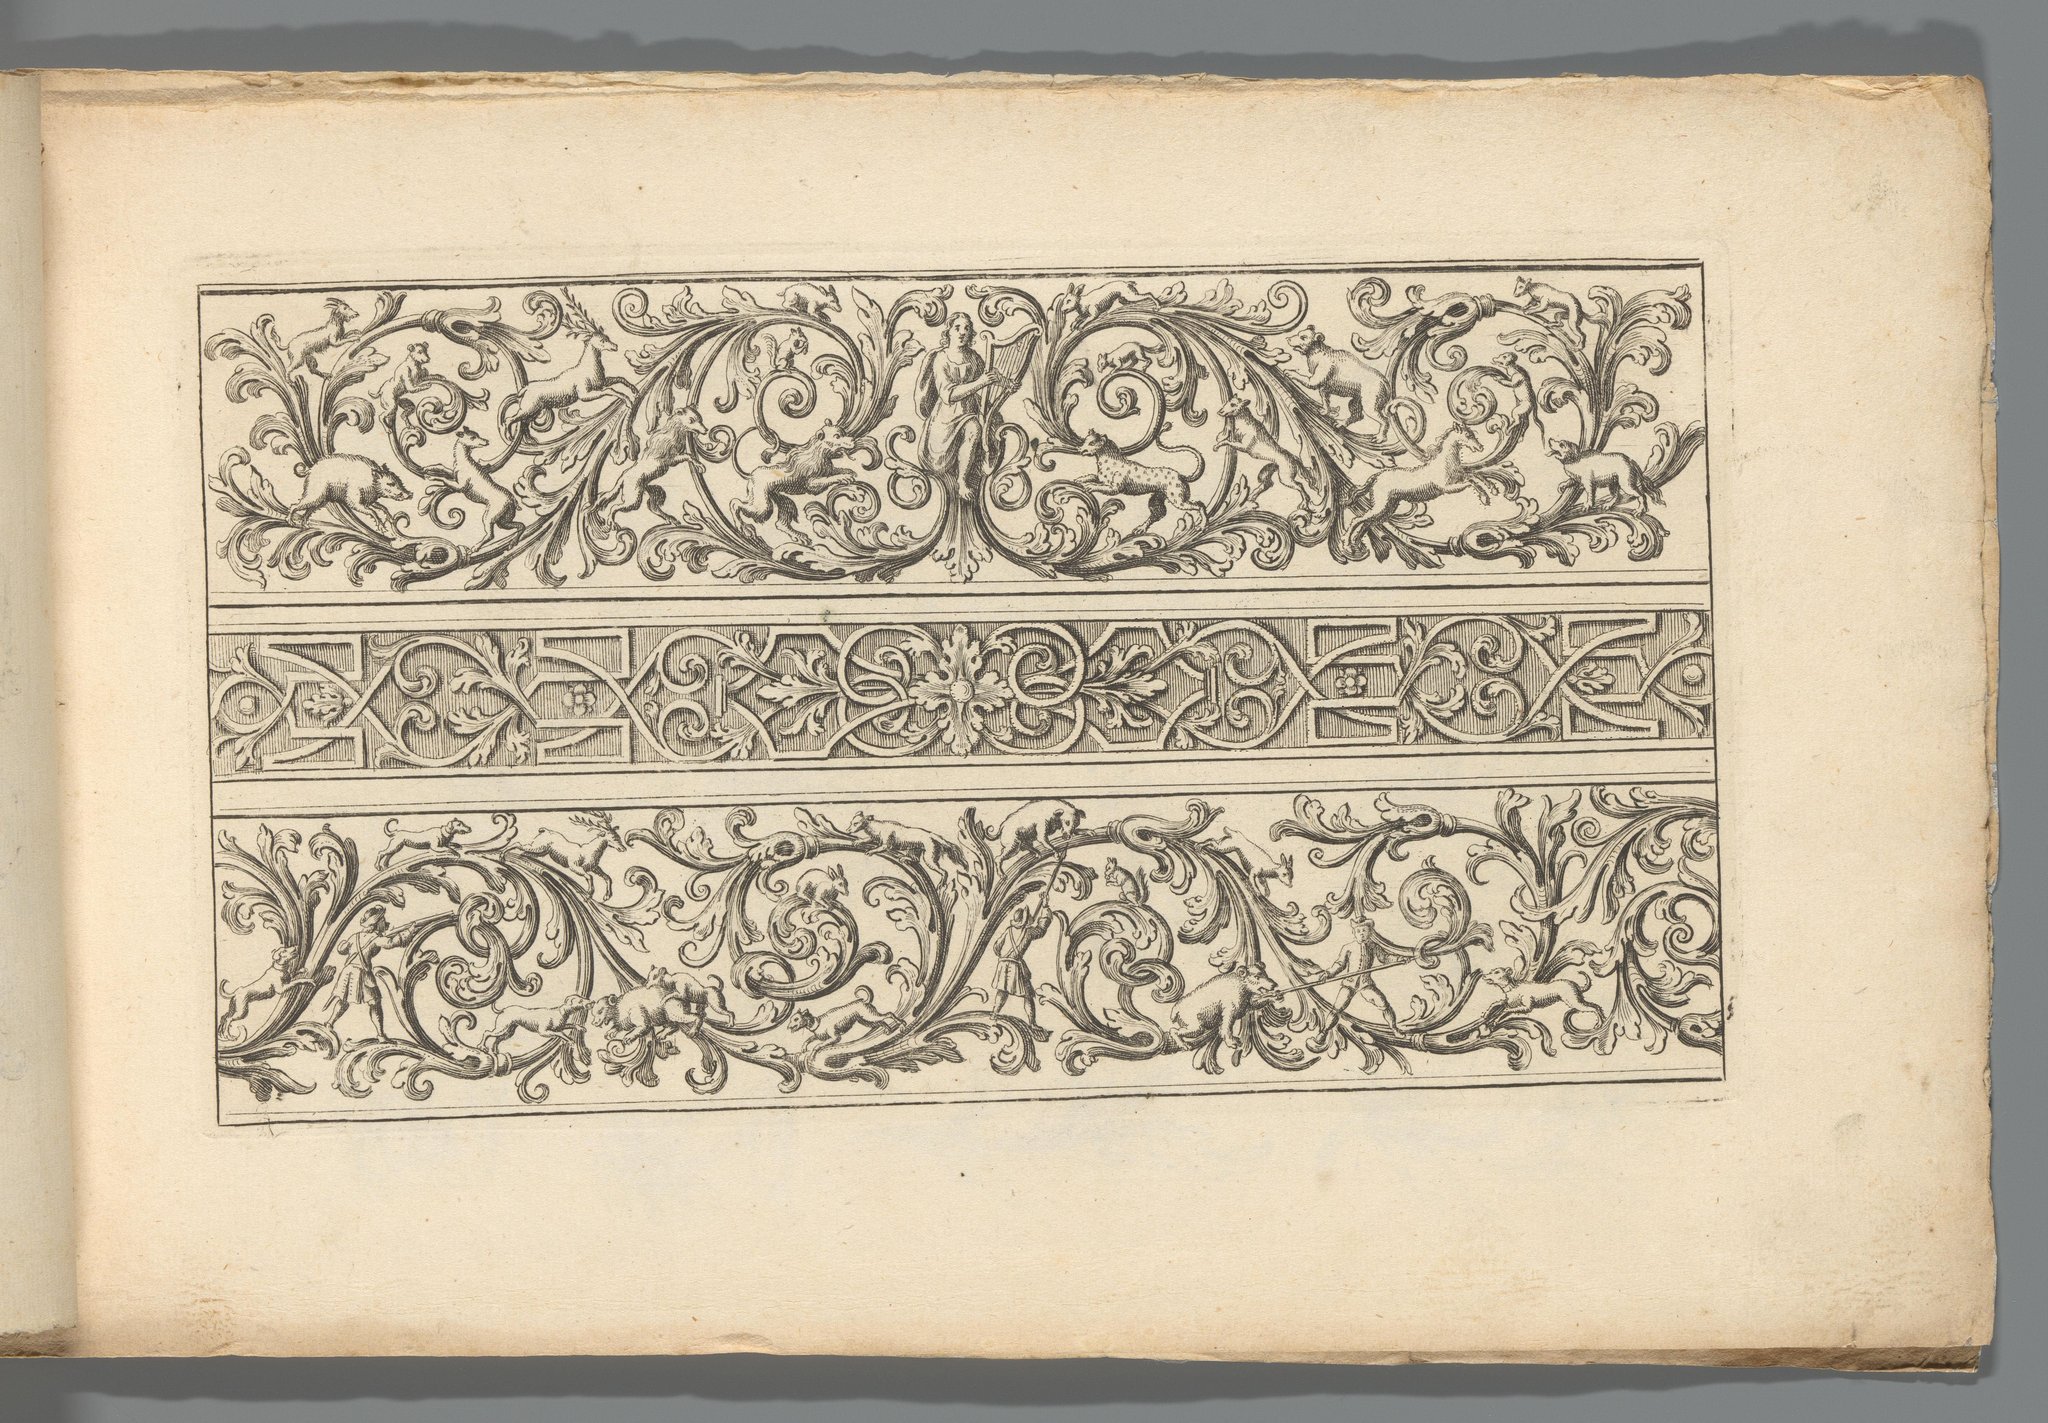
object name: print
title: Vor unterschiedliche Professionen dienliches Laubwerck. Anderer Theil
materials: paper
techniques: etching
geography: nuremberg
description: Drie ornamentele friezen met Apollo, dieren en jagers.